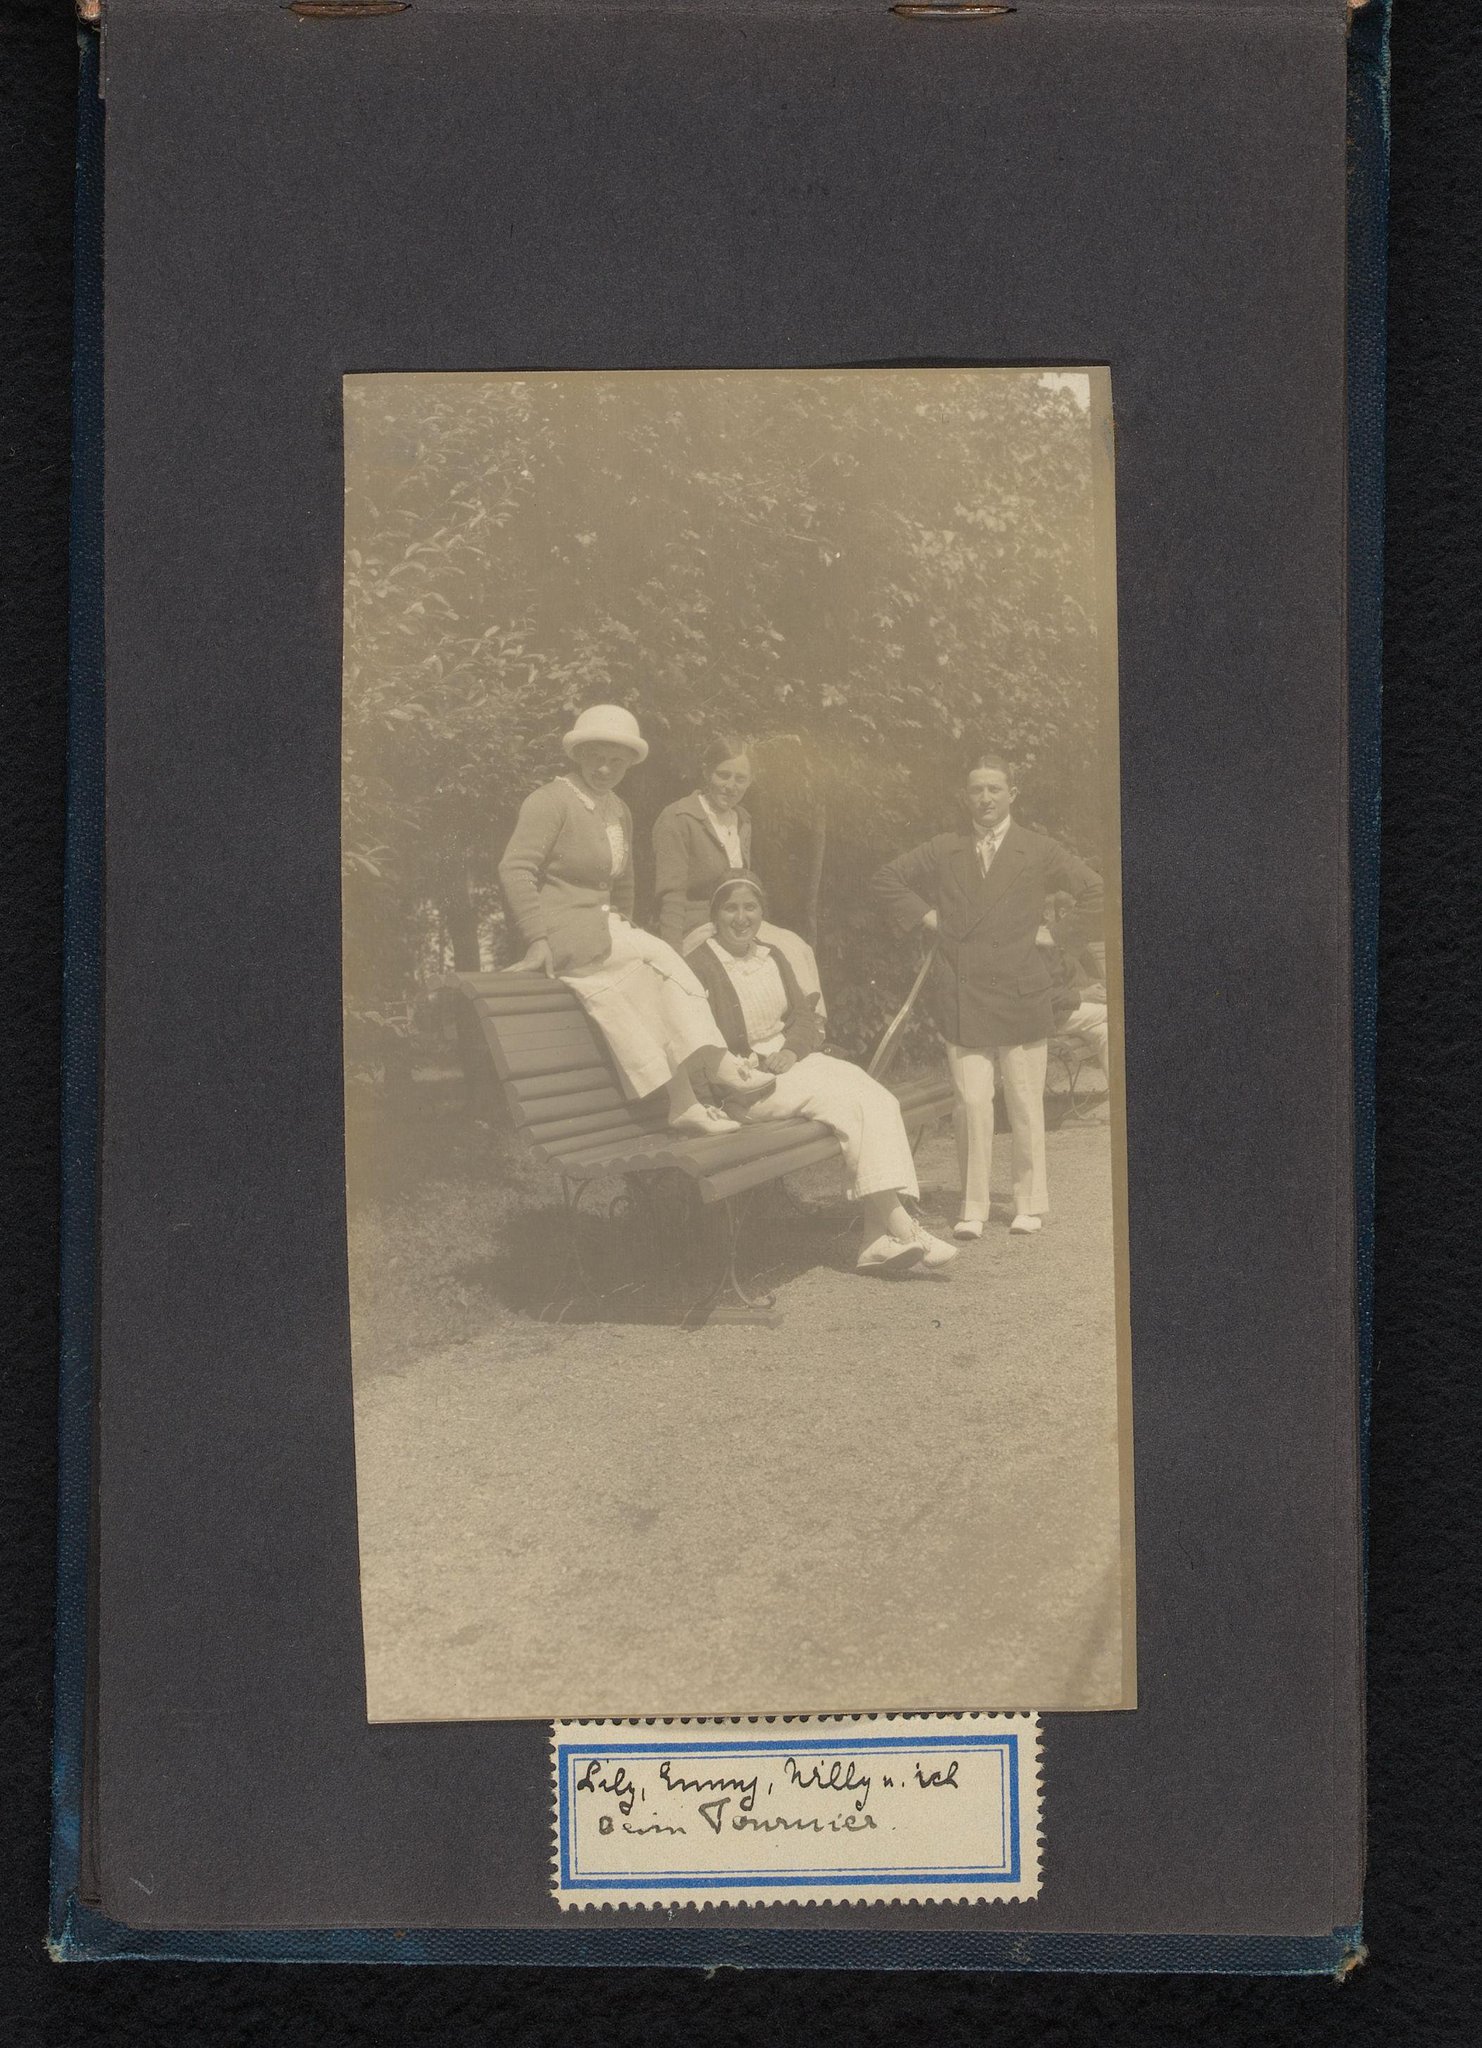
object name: album leaf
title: Lilly, Emmy, Willy en Else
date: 1913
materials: paper, photographic support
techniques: gelatin silver print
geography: switzerland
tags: else wachenheimer-moos, willy moos, tennis, lawn-tennis, historical persons - bb - woman, historical persons, switzerland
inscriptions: inscription: ‘Lily, Emmy, Willy u. ich beim Tournier’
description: Albumblad met een foto van twee vriendinnen Lilly en Emmy, Else en haar broer Willy bij een tennistoernooi in 1913 in Waldhaus, Zwitserland. Onderdeel van het fotoalbum van Else Wachenheimer-Moos en haar broers Arthur en Willy Moos en anderen in de periode 1913-1918.